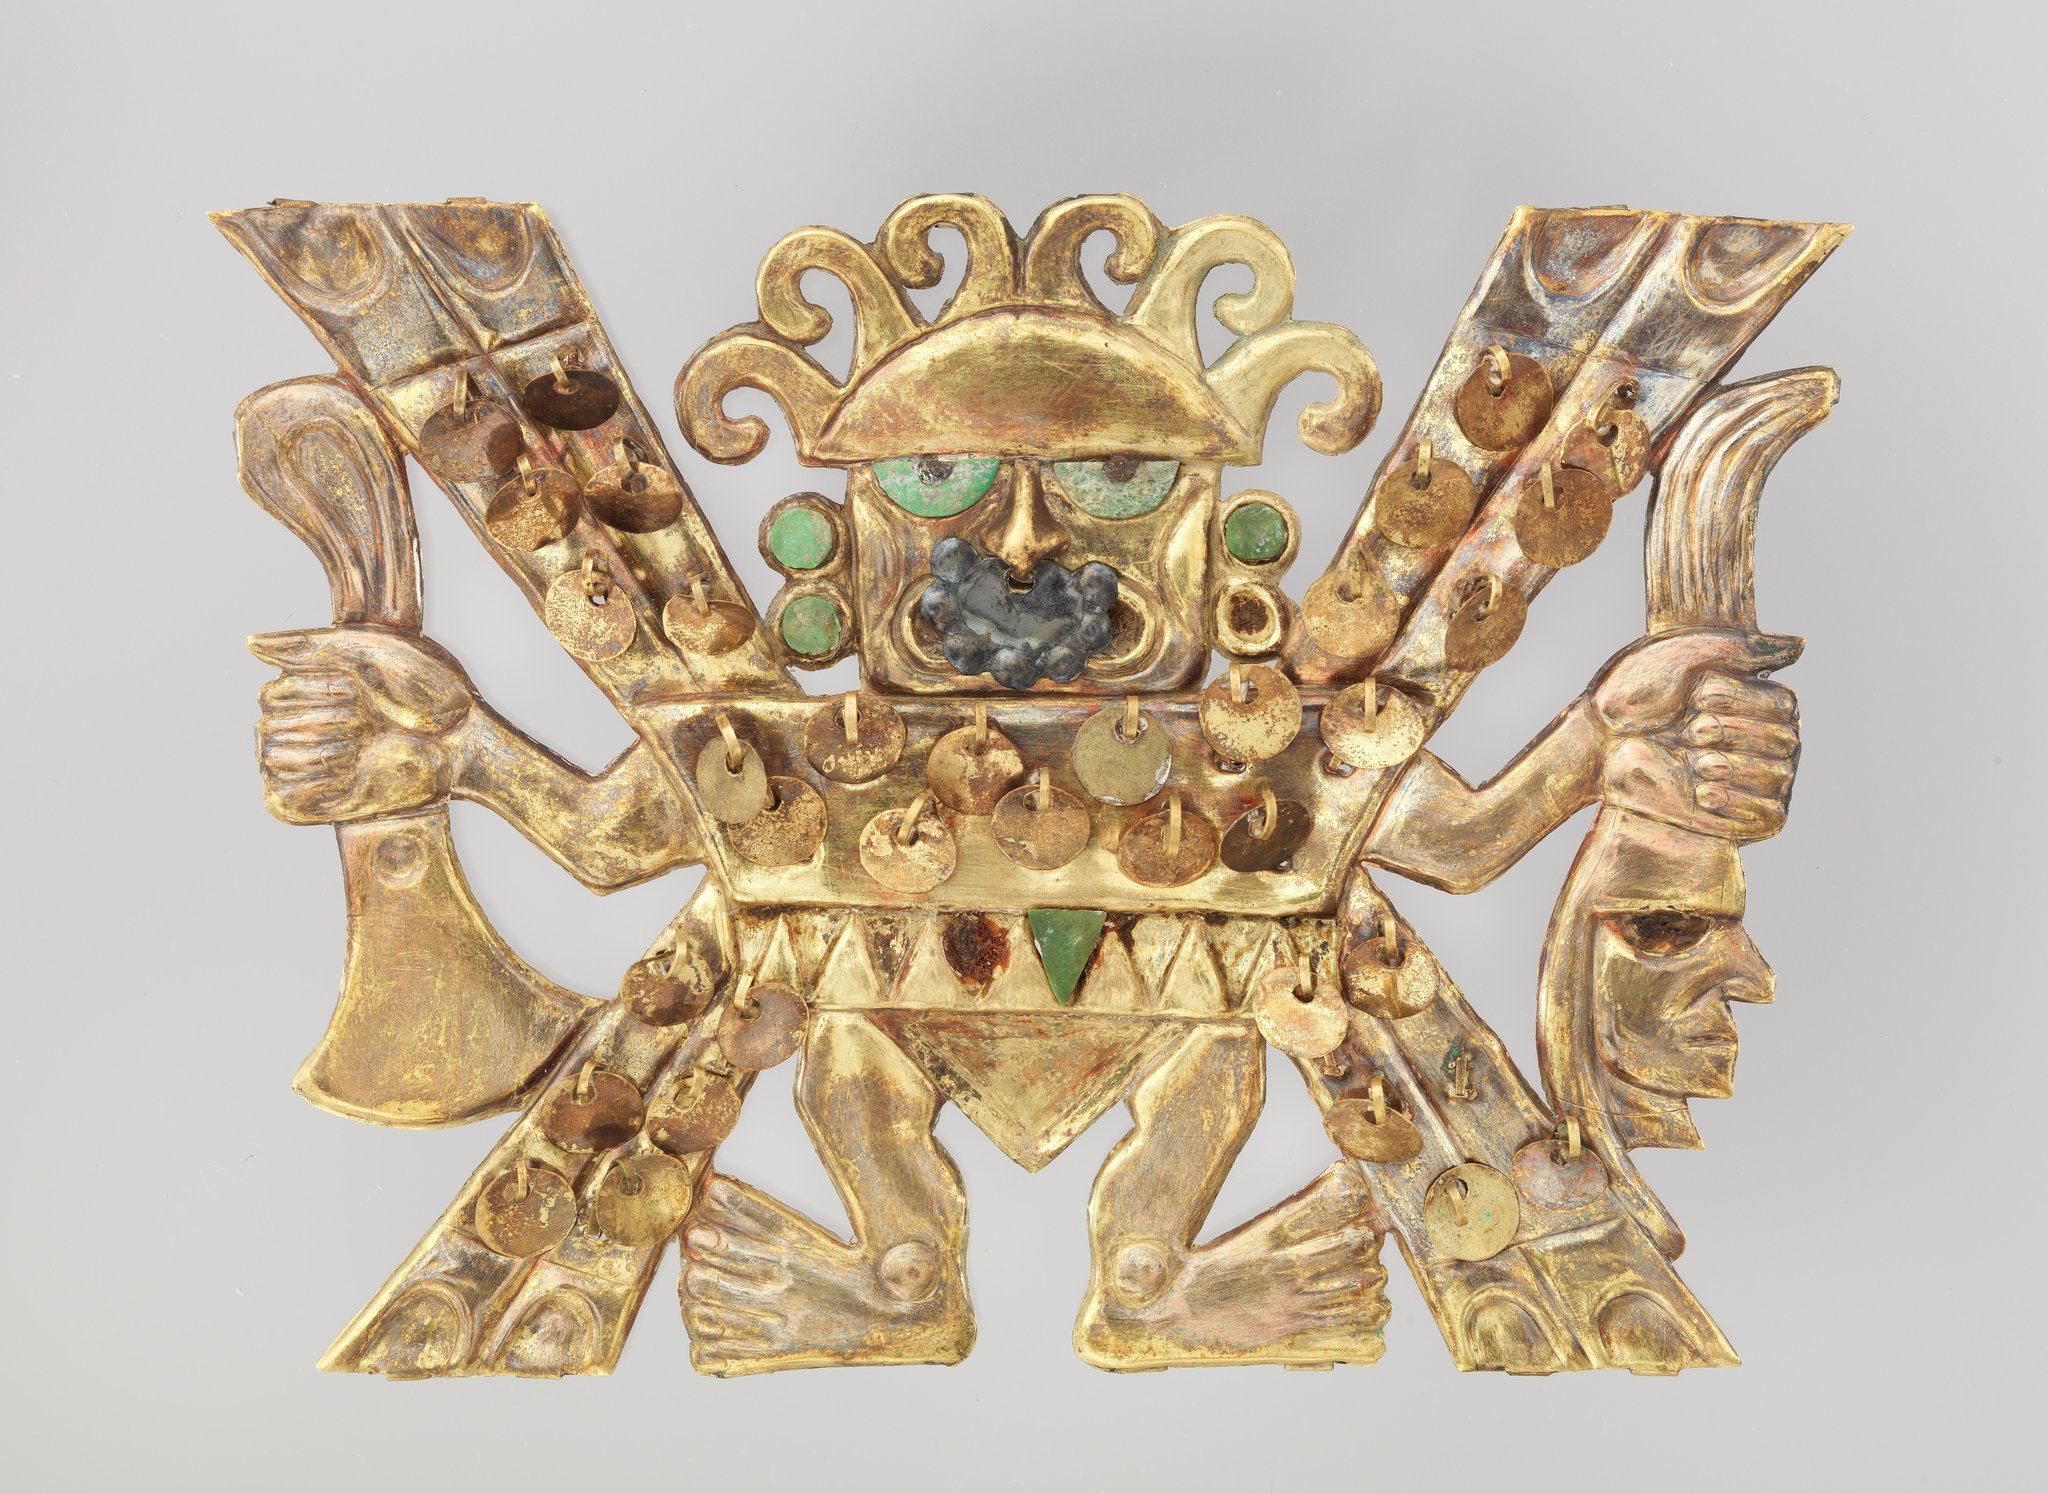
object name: nose ornament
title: Nose ornament with decapitator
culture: moche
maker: moche artist(s)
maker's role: artist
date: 200-900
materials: gilt copper, silver, stone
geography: peru